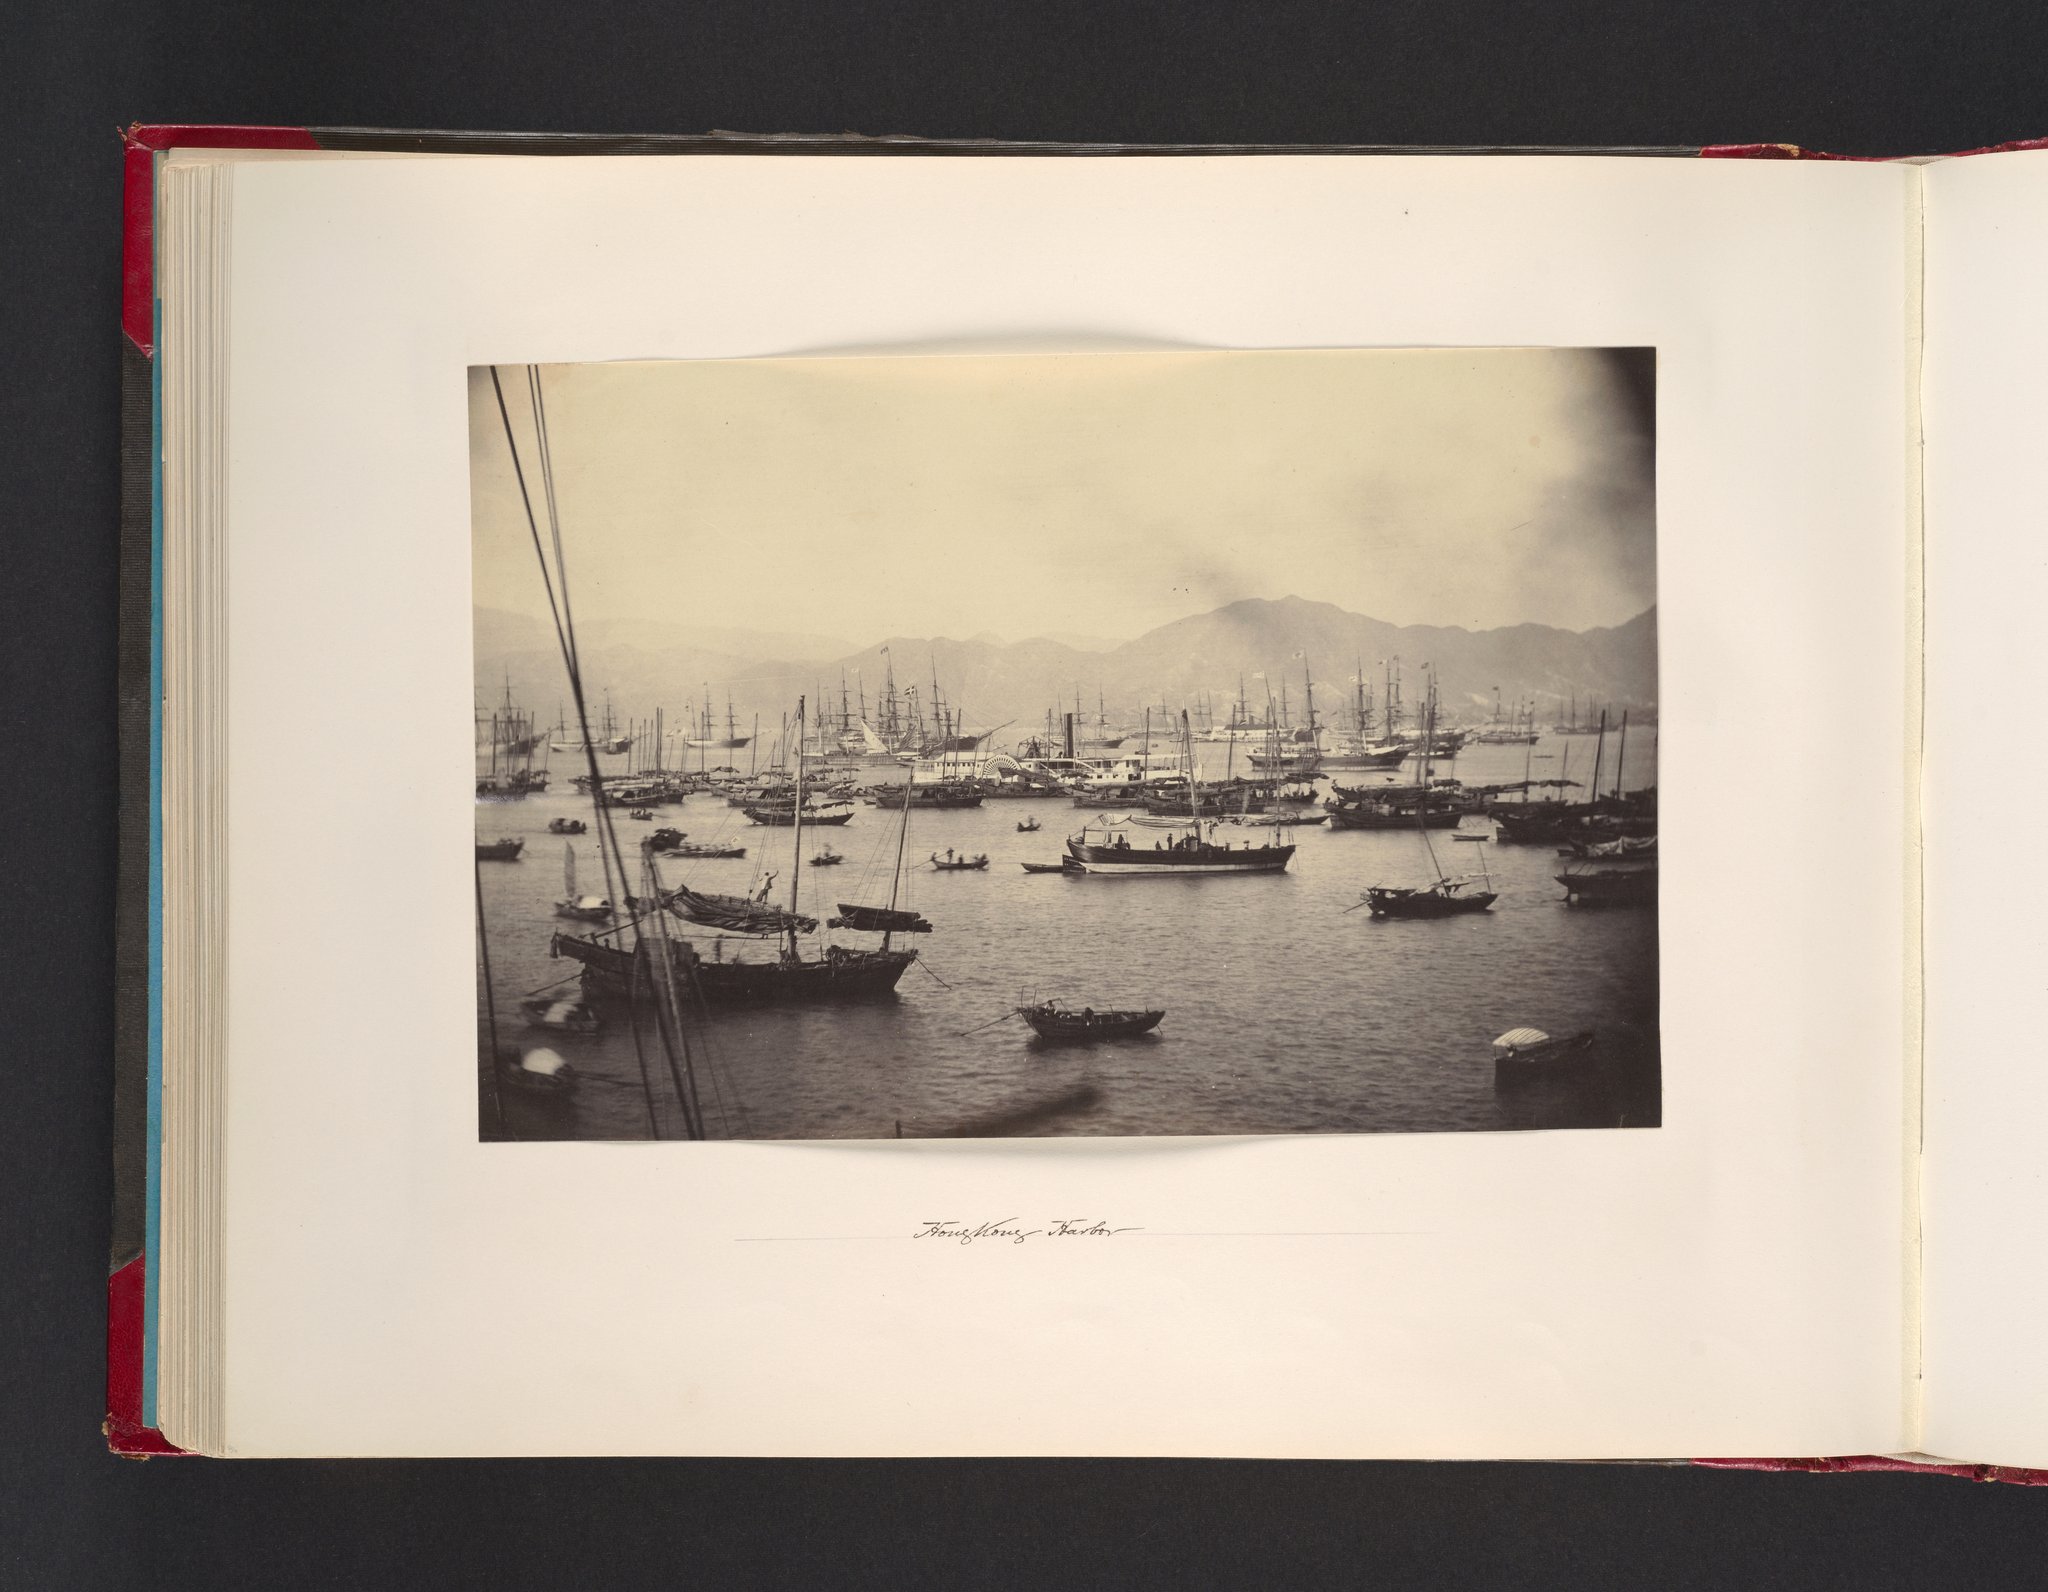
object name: photograph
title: Hong Kong Harbor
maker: john thomson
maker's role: artist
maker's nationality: british, scottish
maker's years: 1837-1921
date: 1865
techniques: albumen silver print, glass negative